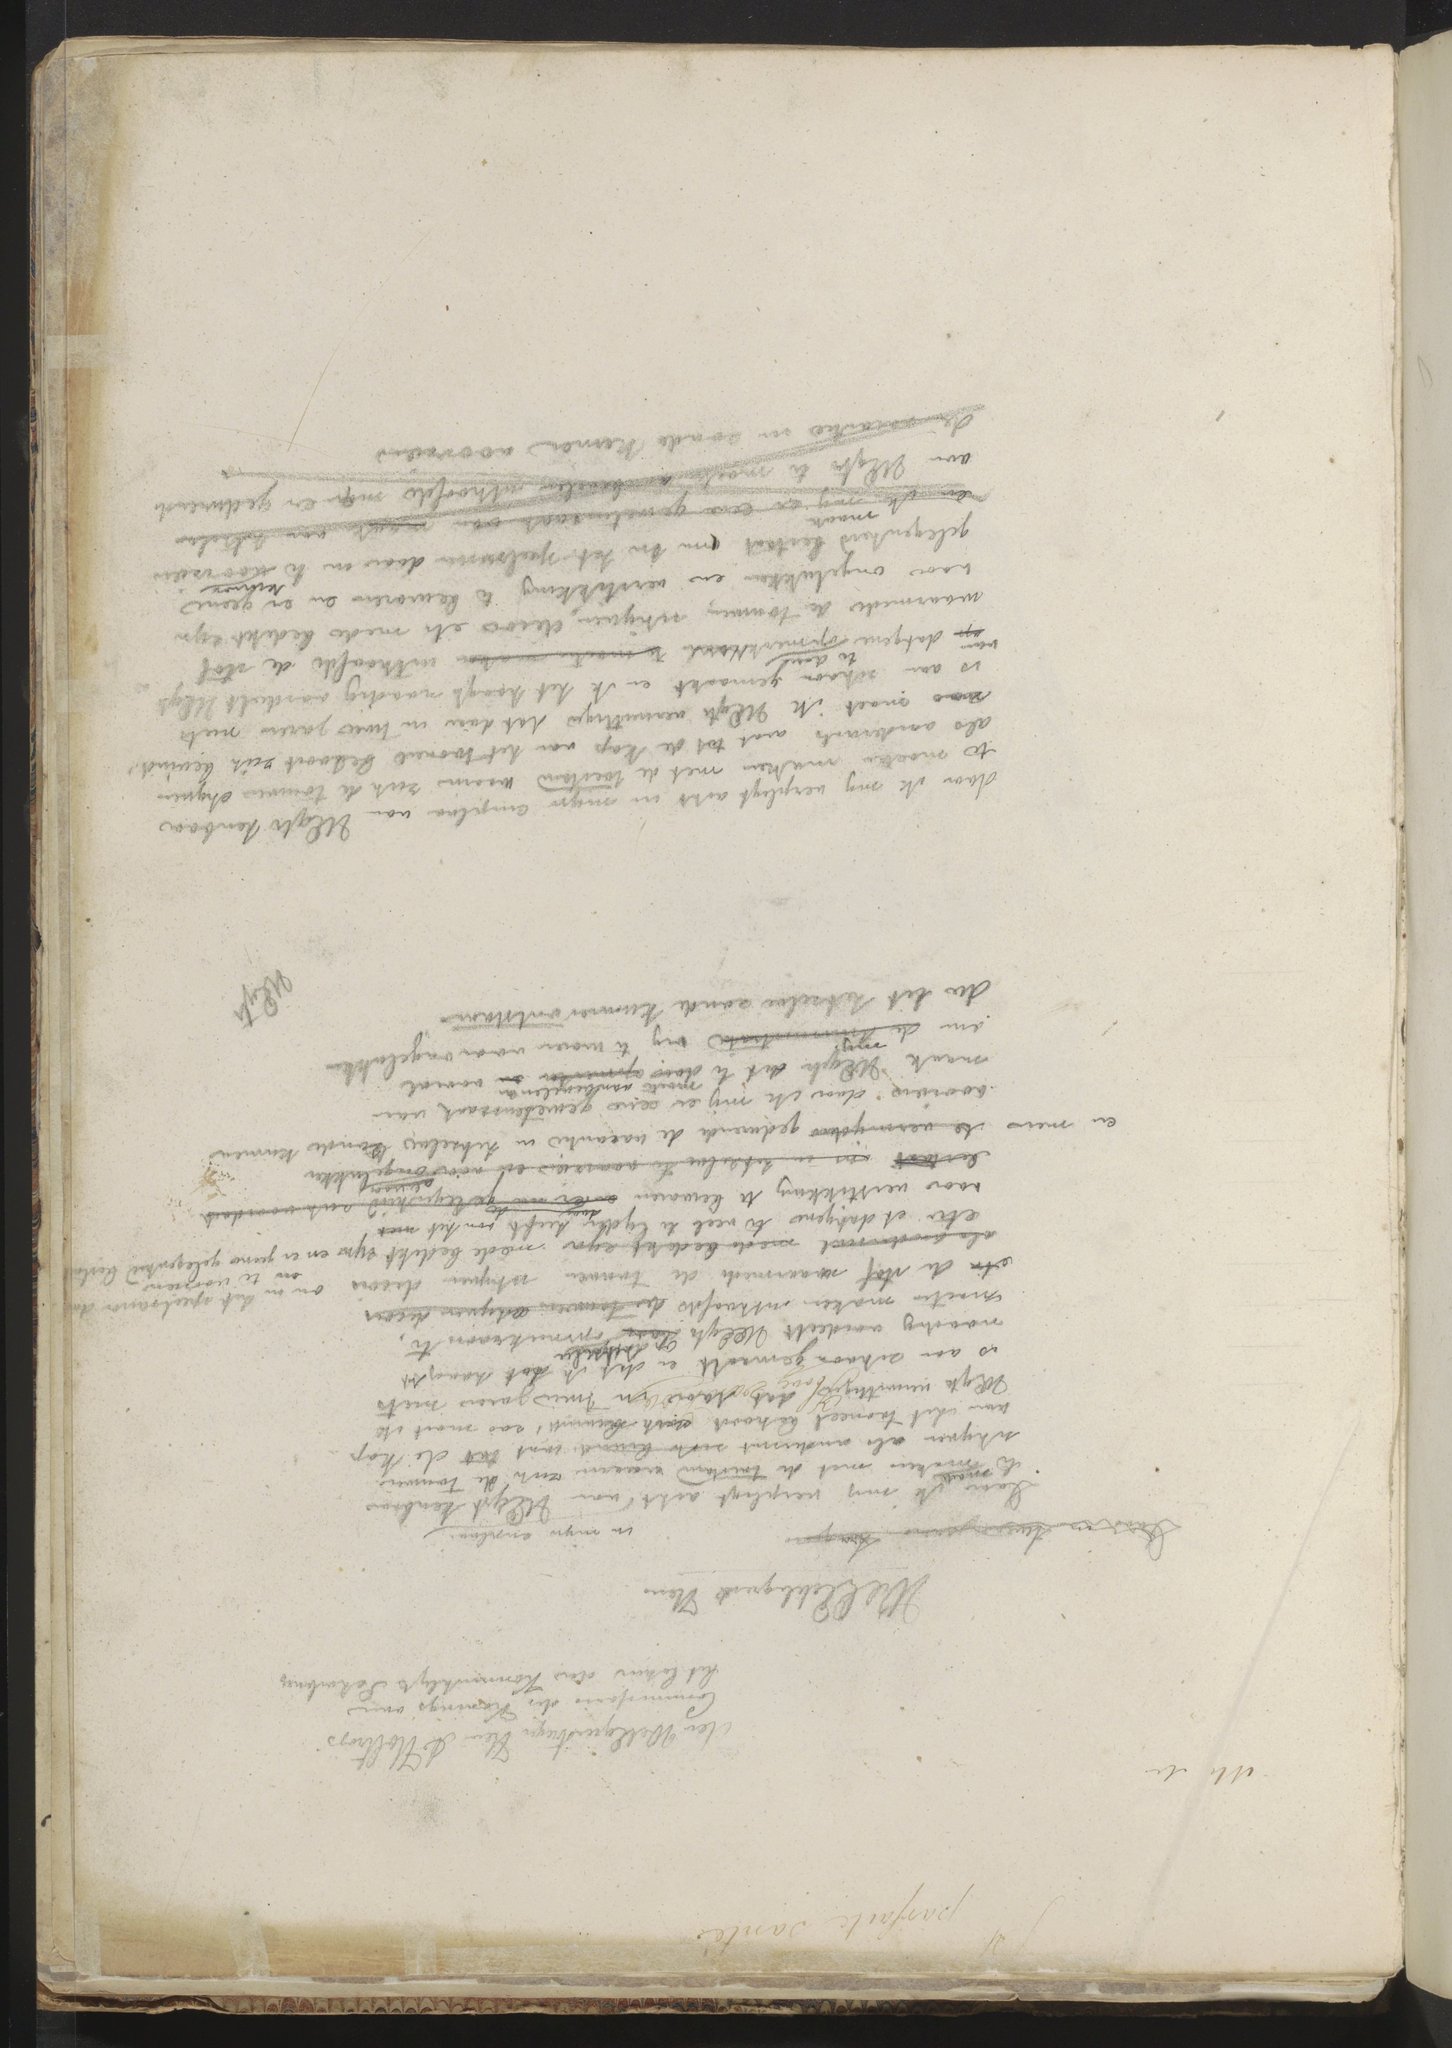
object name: letter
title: Brief aan den heer A. Holtrop, commissaris van de Koning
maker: johannes huybertus van hove bzn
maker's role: print maker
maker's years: 1827-1881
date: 1837-1881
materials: ink, paper, pencil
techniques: pen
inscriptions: annotation: ‘[...]parfaite santé/ [...]/ den WelEgestrengen Heer A Holtrop/ Commissaris der Konings over/ het beheer der Koninklijk Schouburg/ [...]’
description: Blad 30 verso uit een schetsboek met 33 bladen en 10 losse tekeningen.